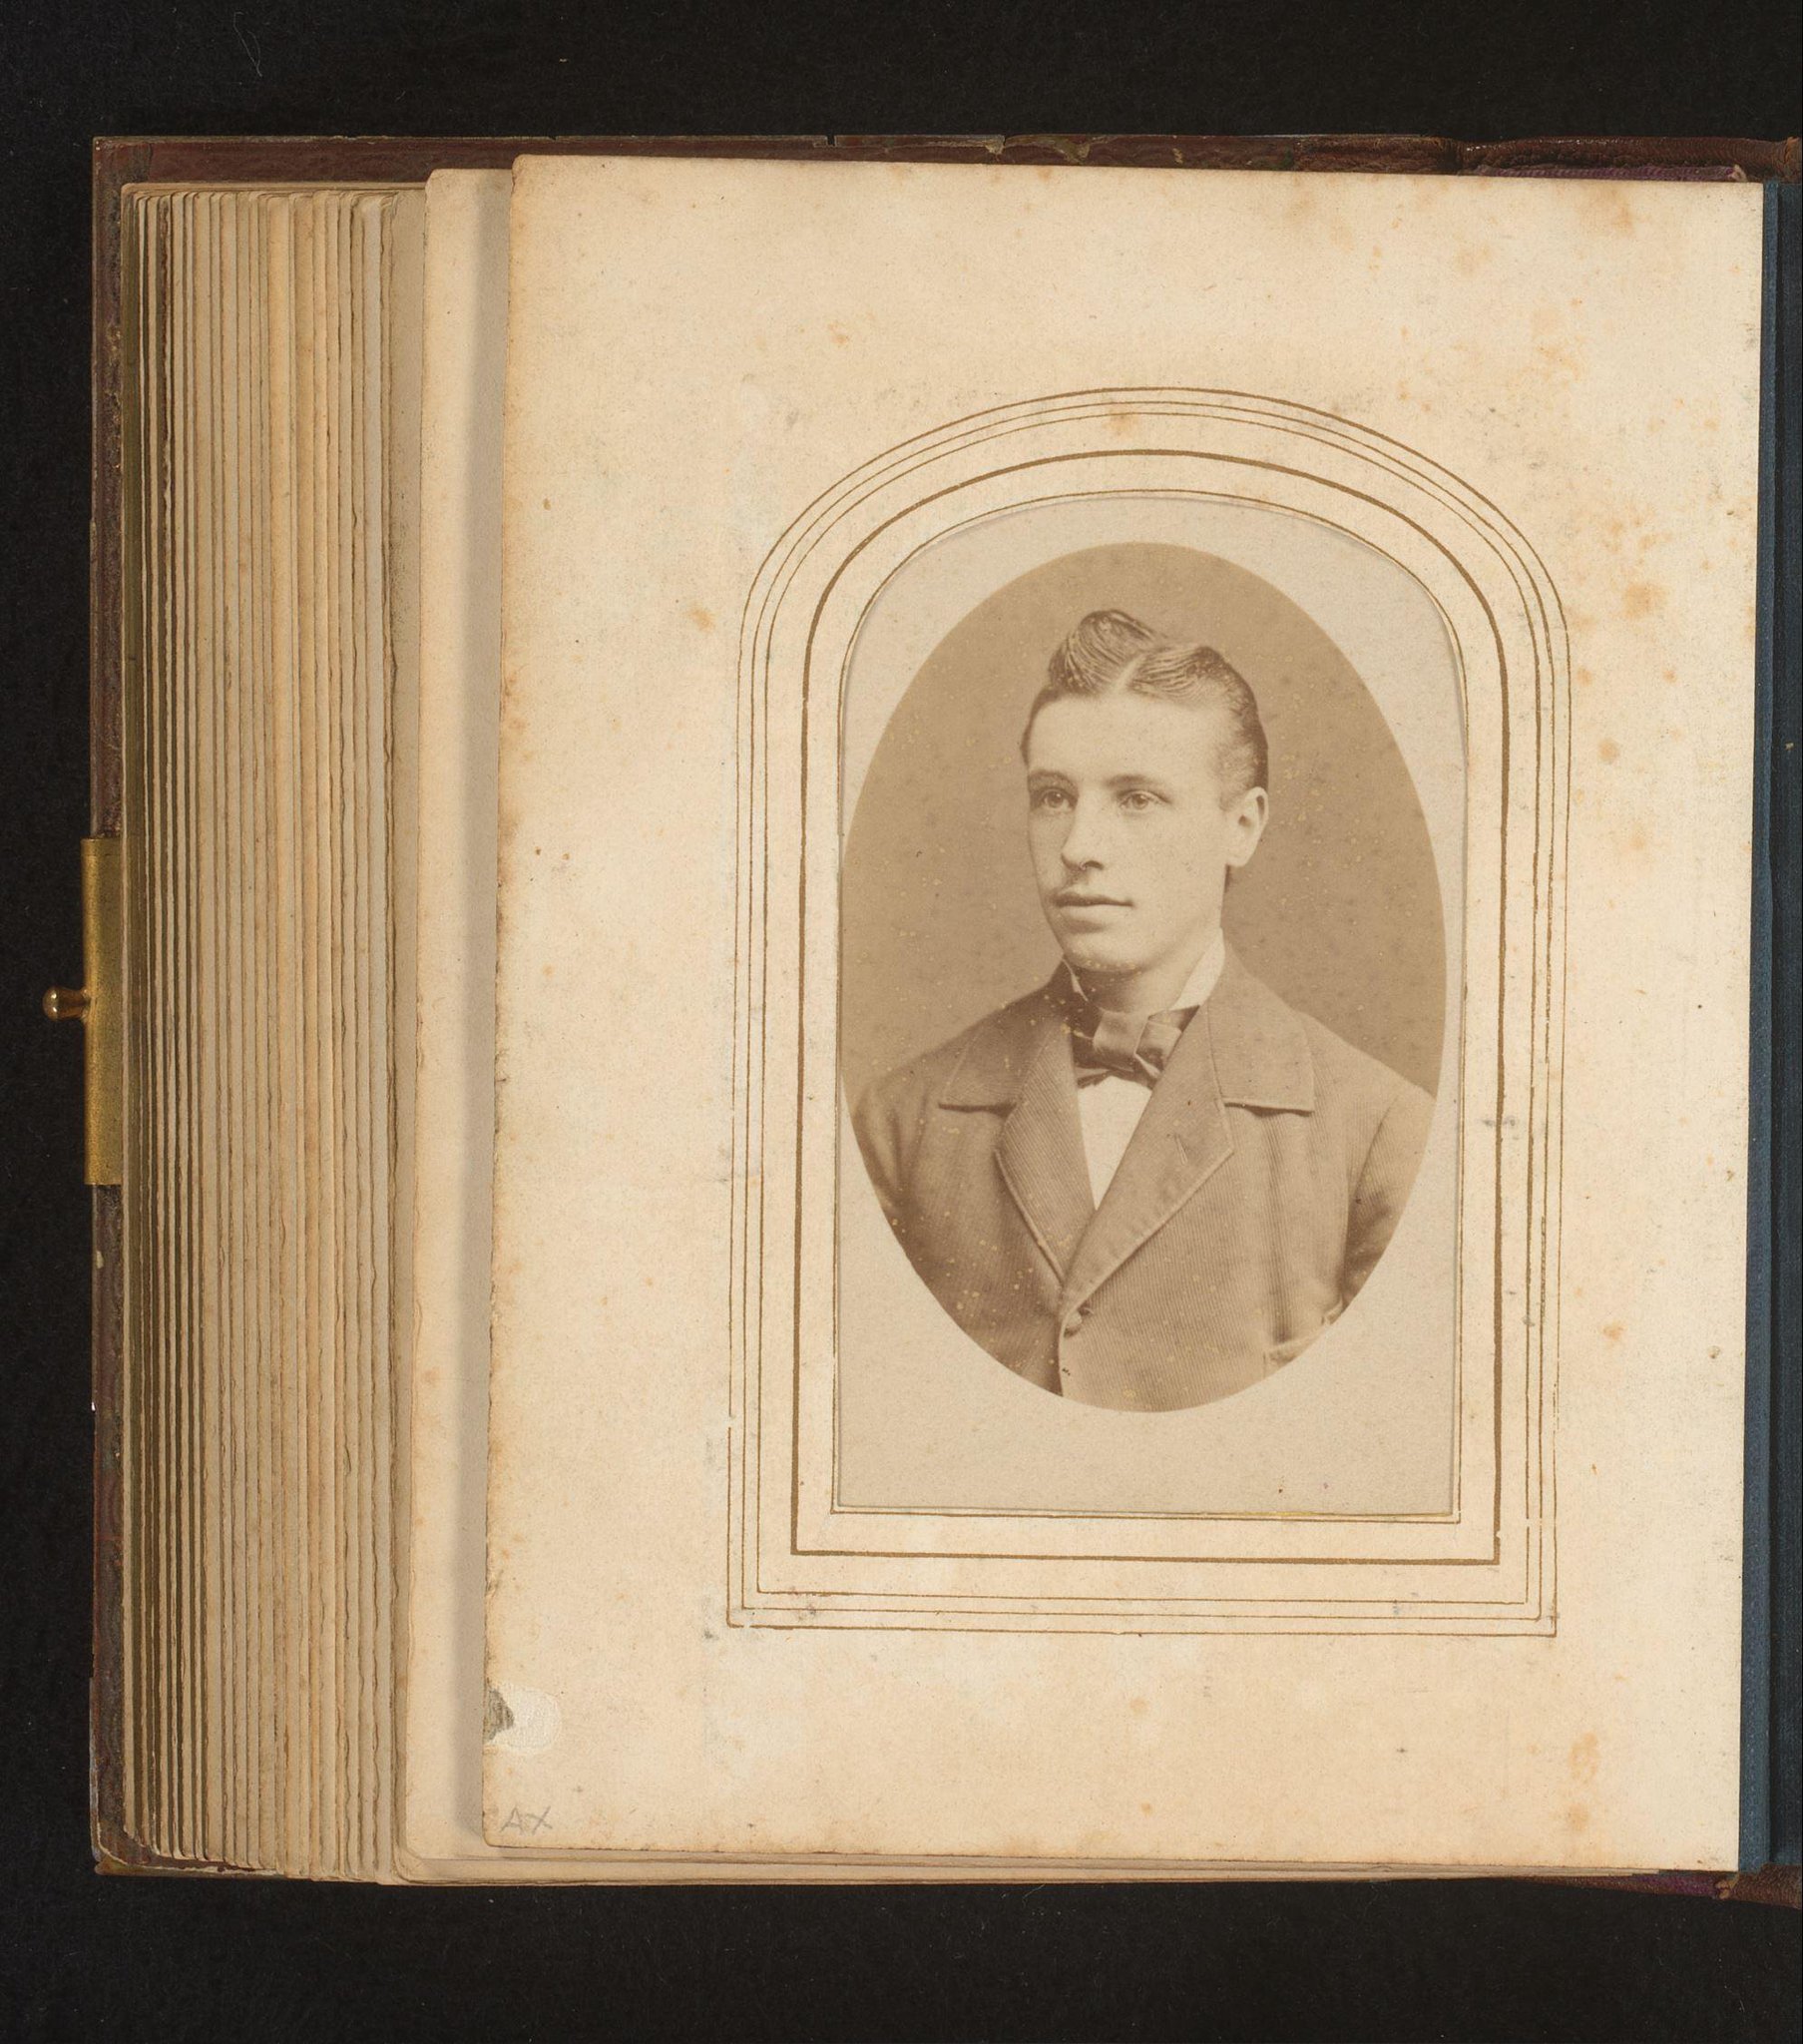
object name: carte de visite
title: Portret van een jonge man met vlinderstrik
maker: friedrich julius von kolkow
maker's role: fotograaf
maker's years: 1839-1914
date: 1876-1900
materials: cardboard, photographic support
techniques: albumen print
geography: groningen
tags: historical persons, youth, adolescent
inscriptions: inscription: ‘wereld-tentoonstelling/ Philadelphia/ groote - prijs medaille./ 1876./ 1873/ VERDIENST-MEDAILLE WEENEN./ Zilverne Voigtländer Medaille Weenen 1875./ Zilverne PrijsMedaillen/ te/ Amsterdam 1866, Groningen 1869, Hoogezand 1872, Appingedam 1874./ Veendam 1873. Winsum 1872./ Warffum 1874./ Fr. Jul. von Kolkow/ Hof-Photograaf/ Z.K.H. Prins Hendrik der Nederlanden/ Groningen.’